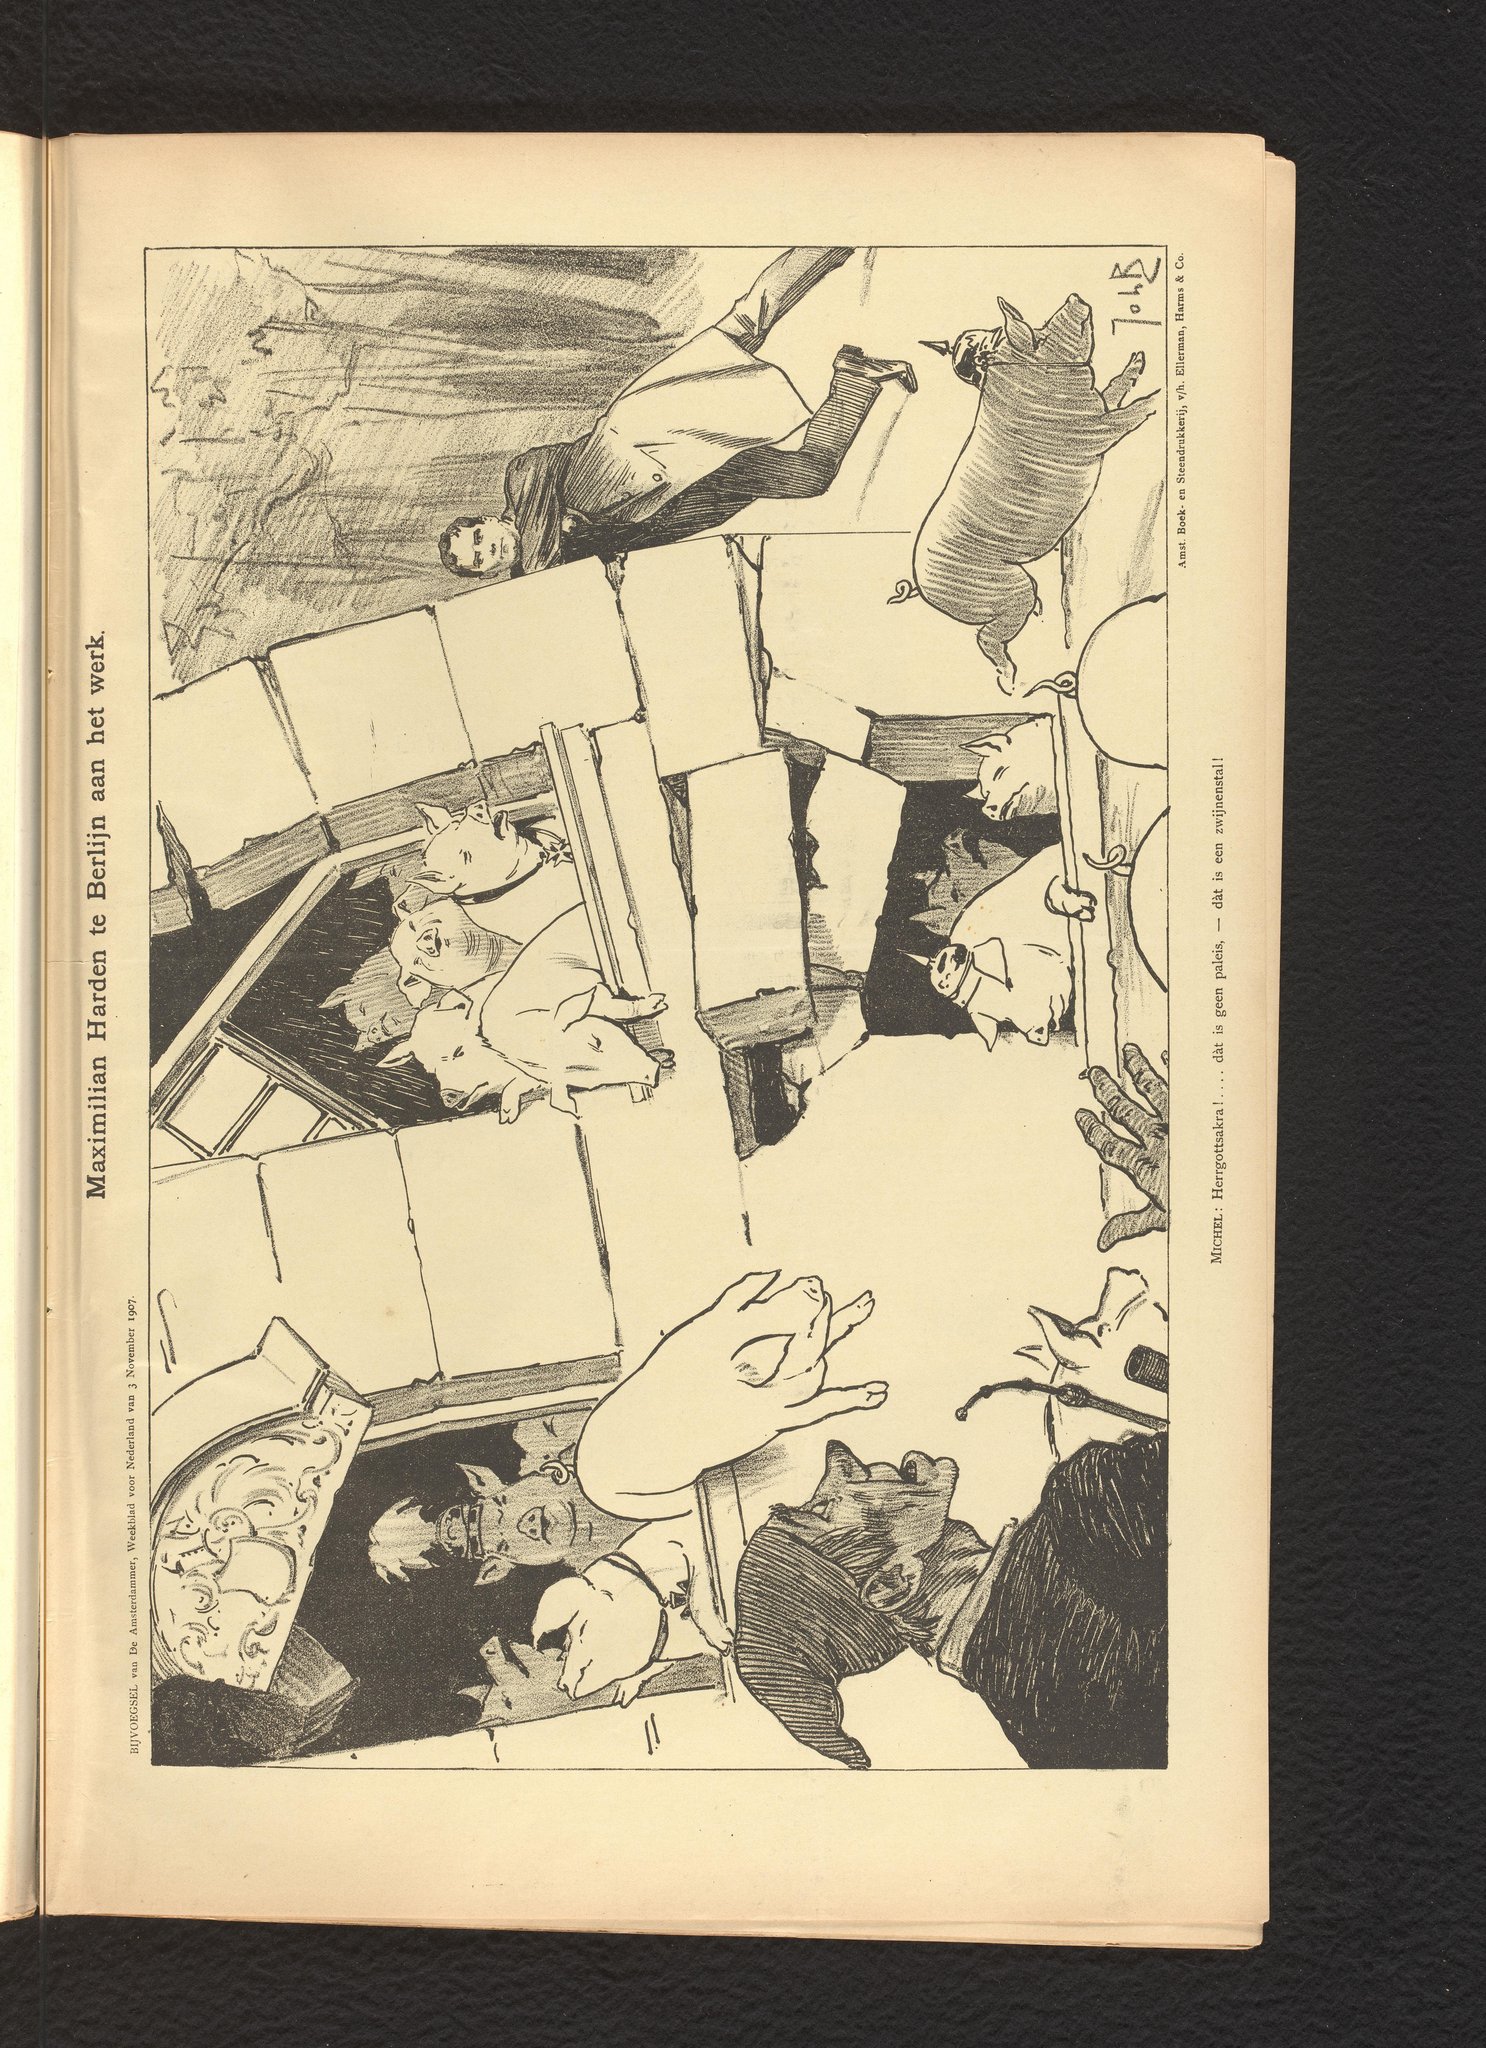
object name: cartoon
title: Maximilian Harden te Berlijn aan het werk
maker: johan braakensiek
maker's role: draughtsman, print maker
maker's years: 1858-1940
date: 1907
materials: paper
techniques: lithograph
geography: netherlands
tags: pig, homosexual love, journalist, reporter, political caricatures and satires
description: De Duitse journalist Maximilian Harden duwt een gebouw omver waardoor alle varkens, sommige getooid met Duitse pickelhaube, moeten vluchten. Michel (het Duitse volk) kijkt verbijsterd toe. Naar aanleiding van onthullingen door Harder over homoseksueel gedrag in de kringen rondom keizer Wilhelm II.